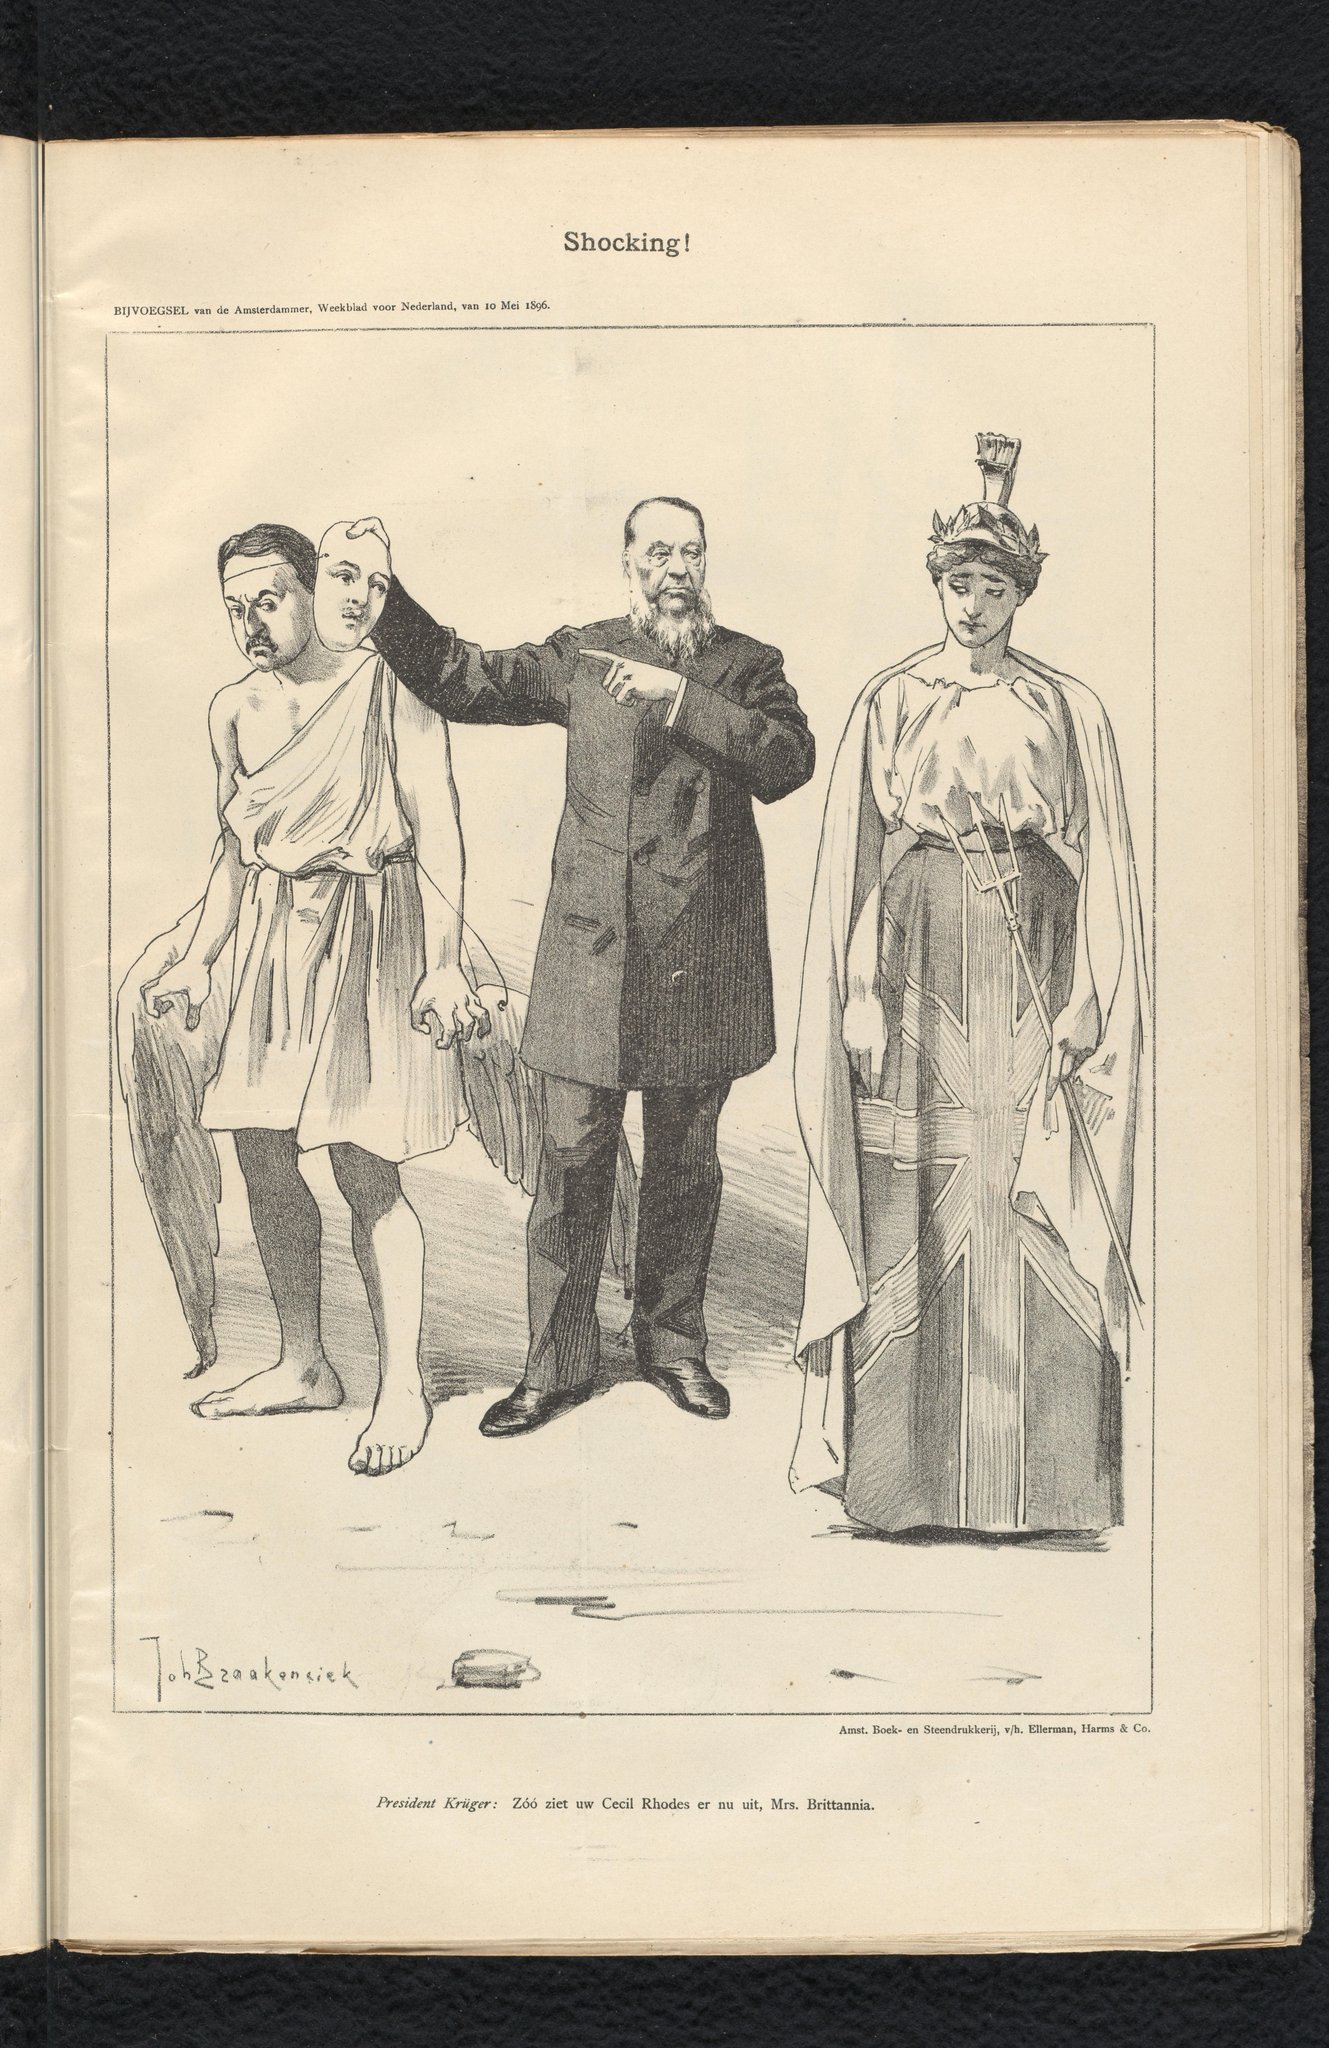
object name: cartoon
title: Shocking!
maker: johan braakensiek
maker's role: draughtsman, print maker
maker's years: 1858-1940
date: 1896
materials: paper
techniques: lithograph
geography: amsterdam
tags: london, mask, personifications of countries, nations, states, districts, etc.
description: Paul Kruger ontmaskert Leander Starr Jameson die een masker droeg van Cecil Rhodes ten overstaan van de Britse Maagd.